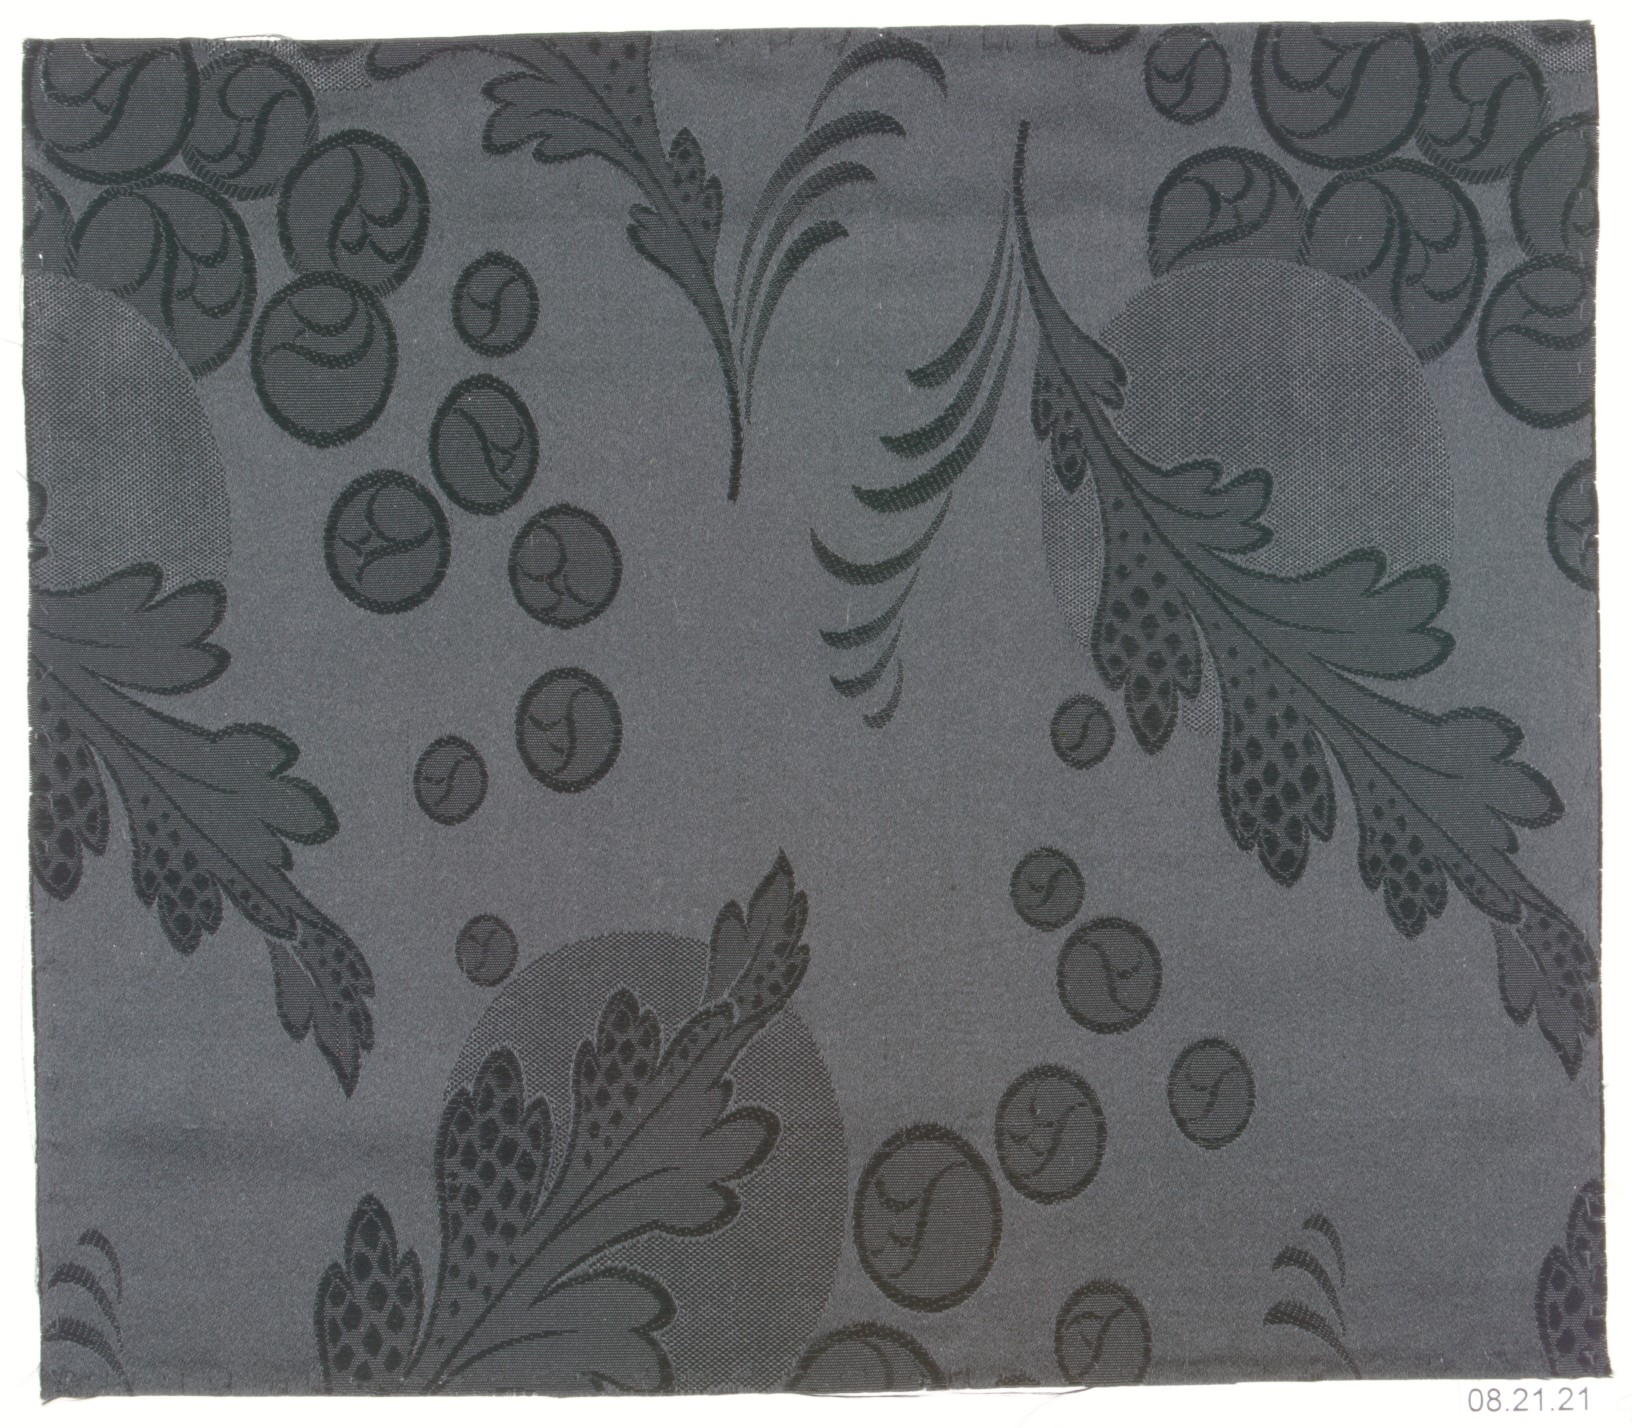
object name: textile sample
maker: Anonymous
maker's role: designer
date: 1900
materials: silk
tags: leaves